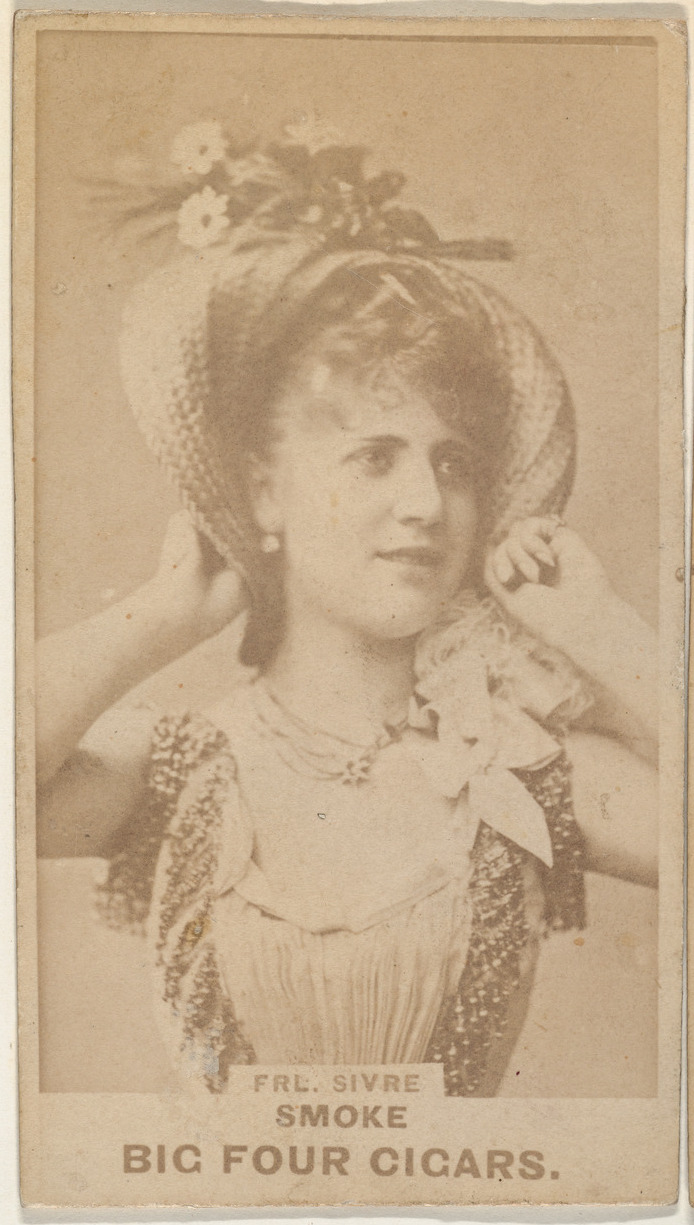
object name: photograph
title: Fraulein Sivre, from the Actresses series (N669) promoting Big Four Cigars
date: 1888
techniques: albumen silver print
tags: portraits,women,actresses